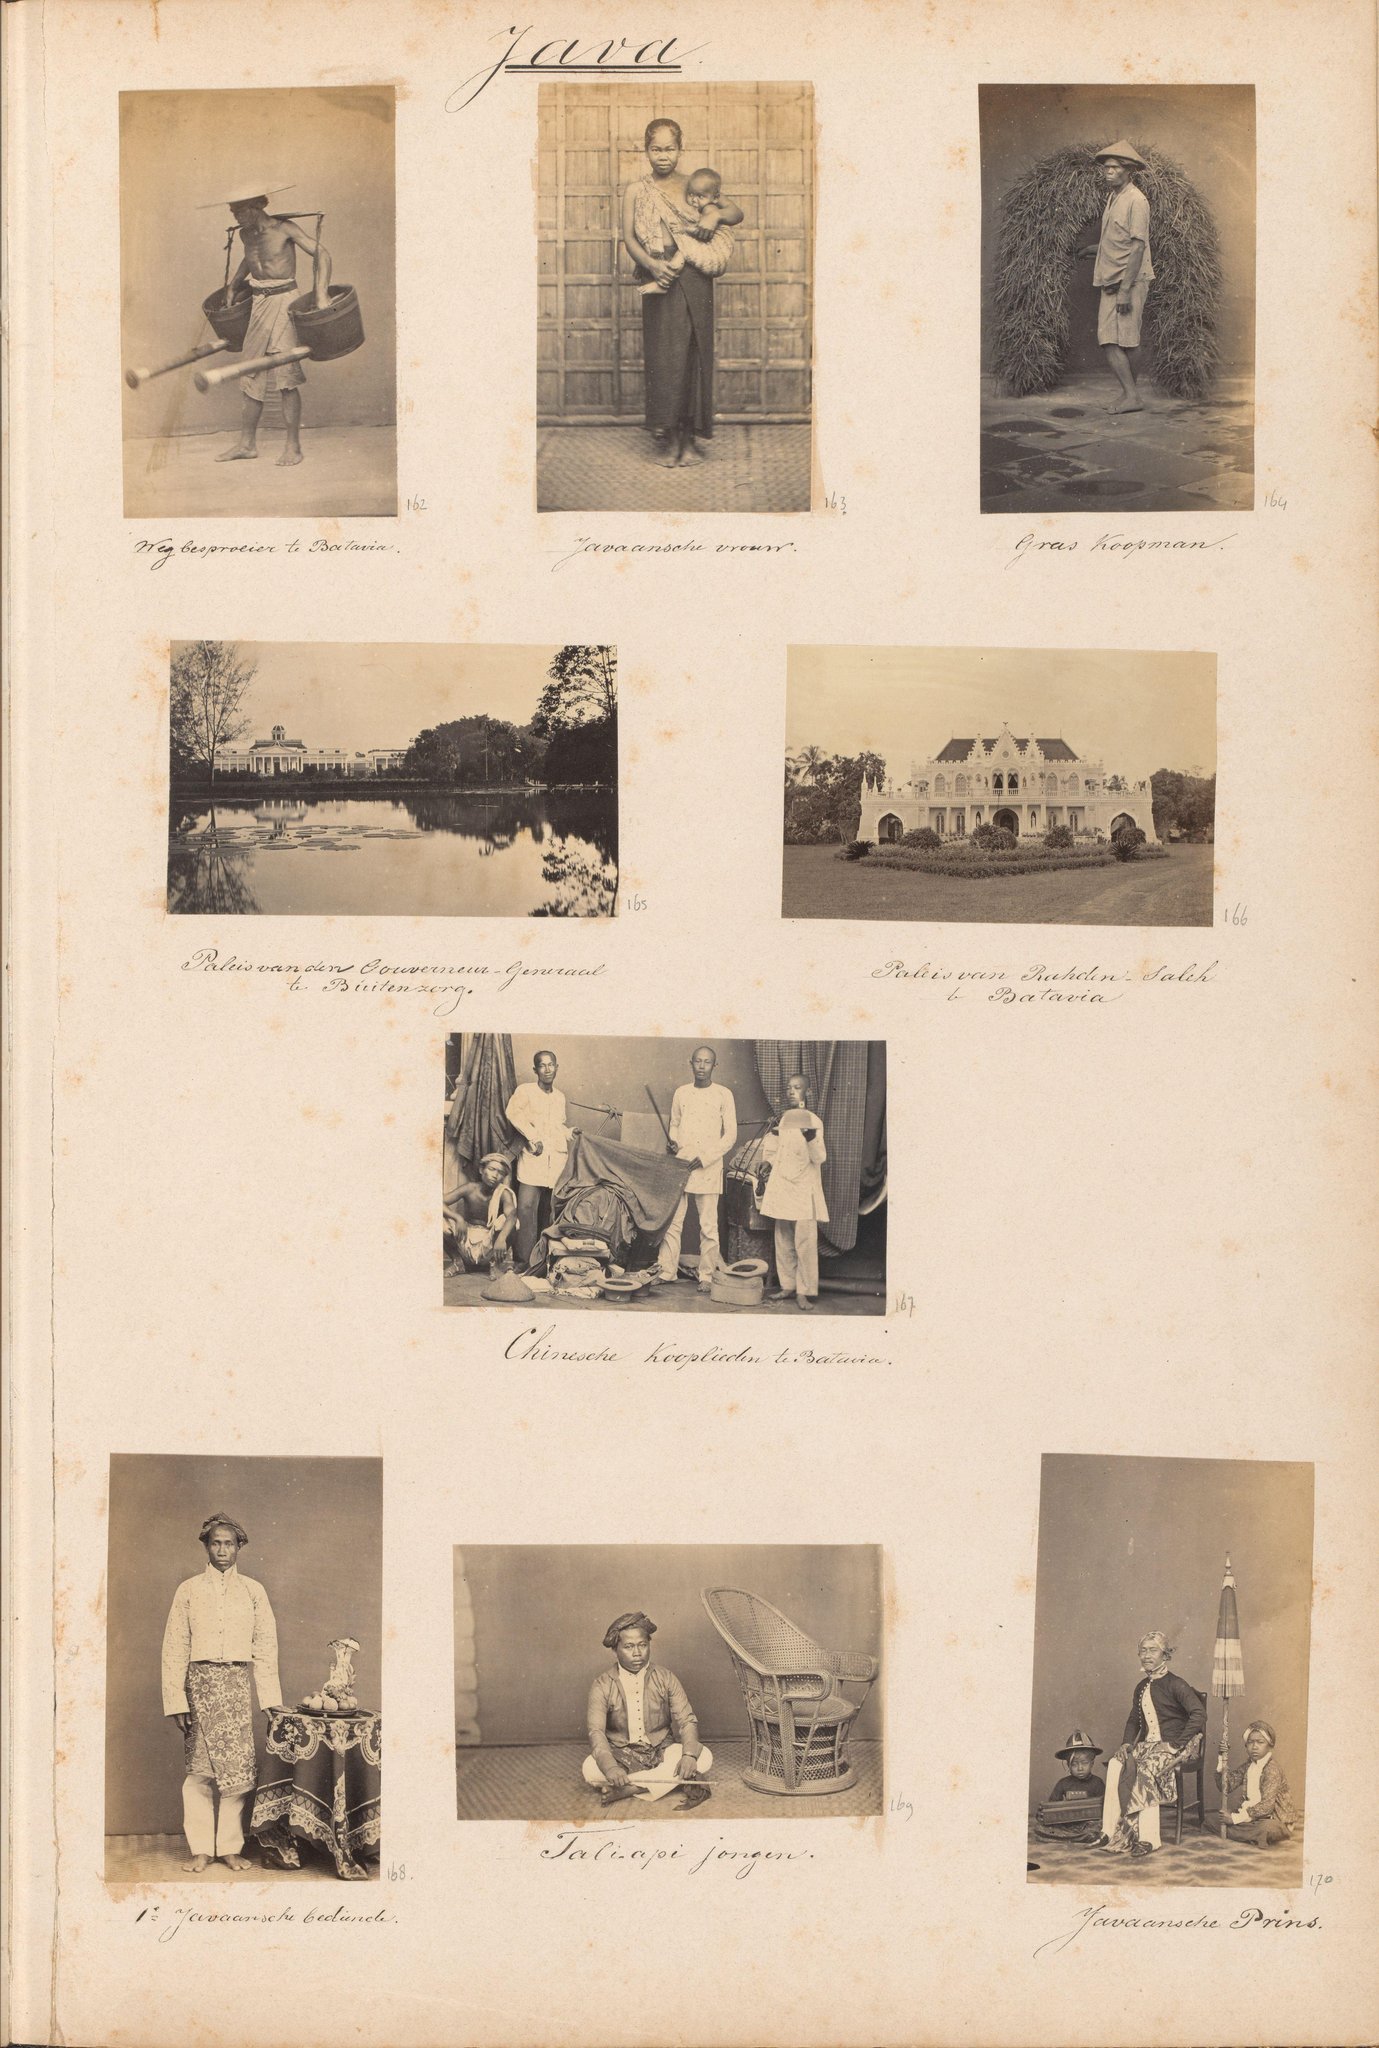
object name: photograph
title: Portret van een zittende Javaanse man, aangeduid als 'Tali-api jongen'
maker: Anonymous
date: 1870-1880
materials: paper, photographic support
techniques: albumen print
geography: java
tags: house personnel, servants, java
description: Onderdeel van Fotoalbum van Robert Daniel Crommelin (1841-1907).